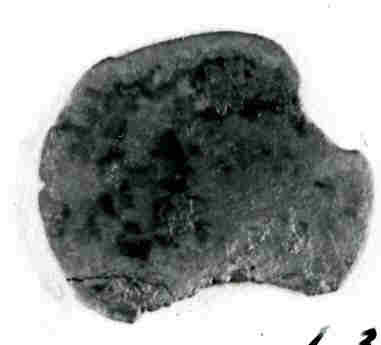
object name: coin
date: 401-1400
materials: copper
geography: iran